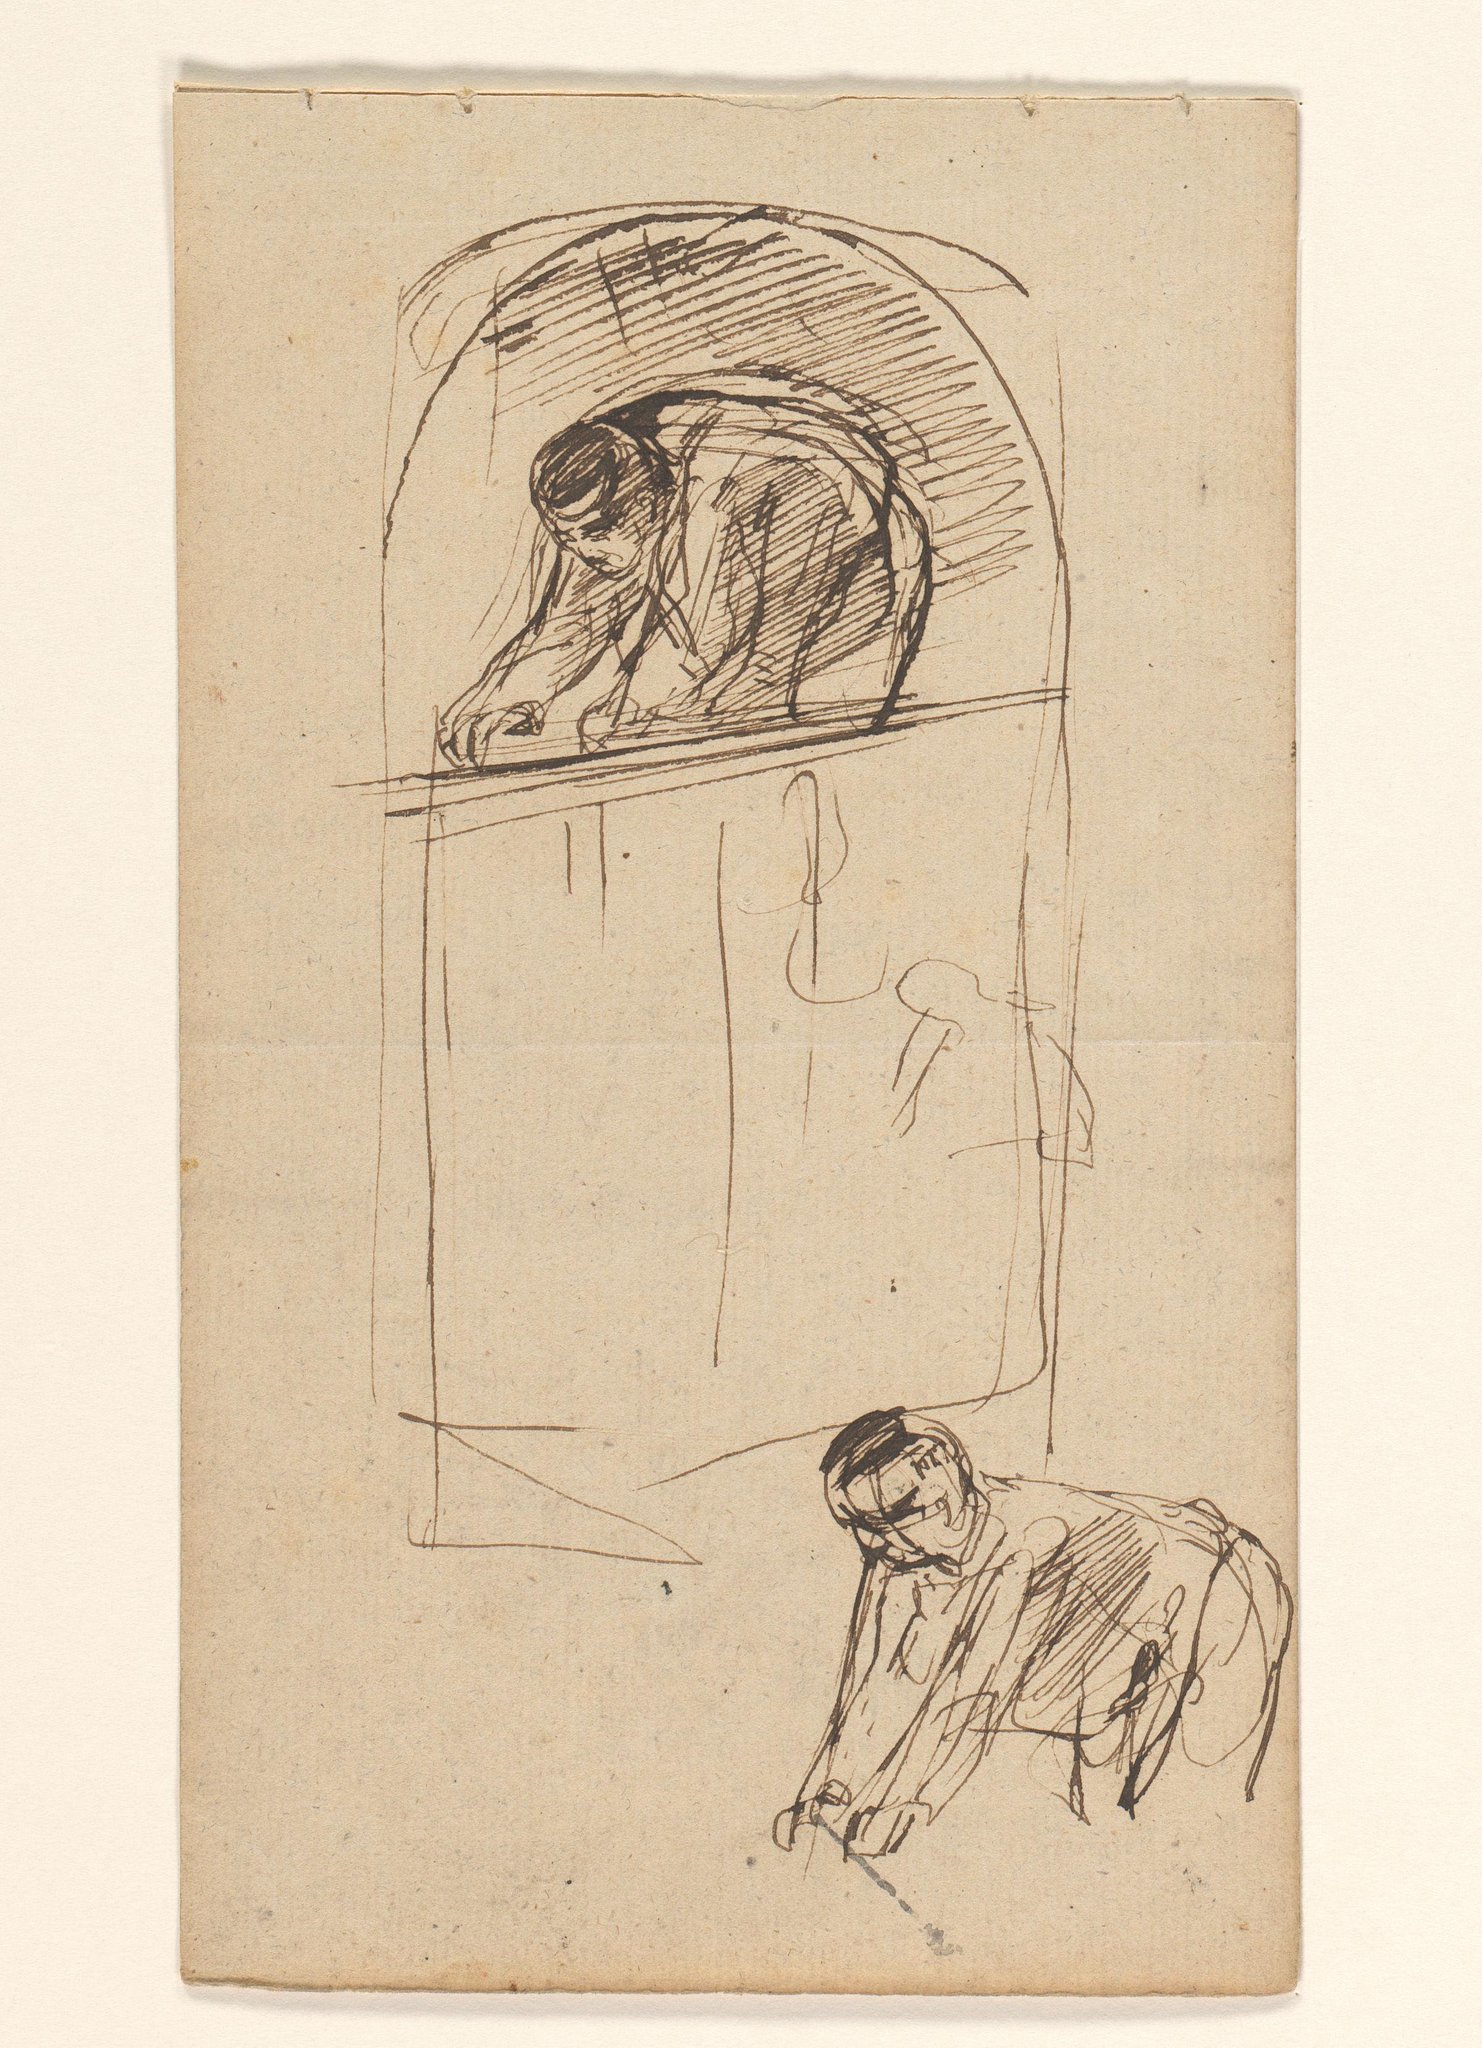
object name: drawing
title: Schetsblad met twee studies van een bukkende man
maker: august allebé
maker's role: draughtsman, print maker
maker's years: 1838-1927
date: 1848-1927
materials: ink, paper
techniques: pen